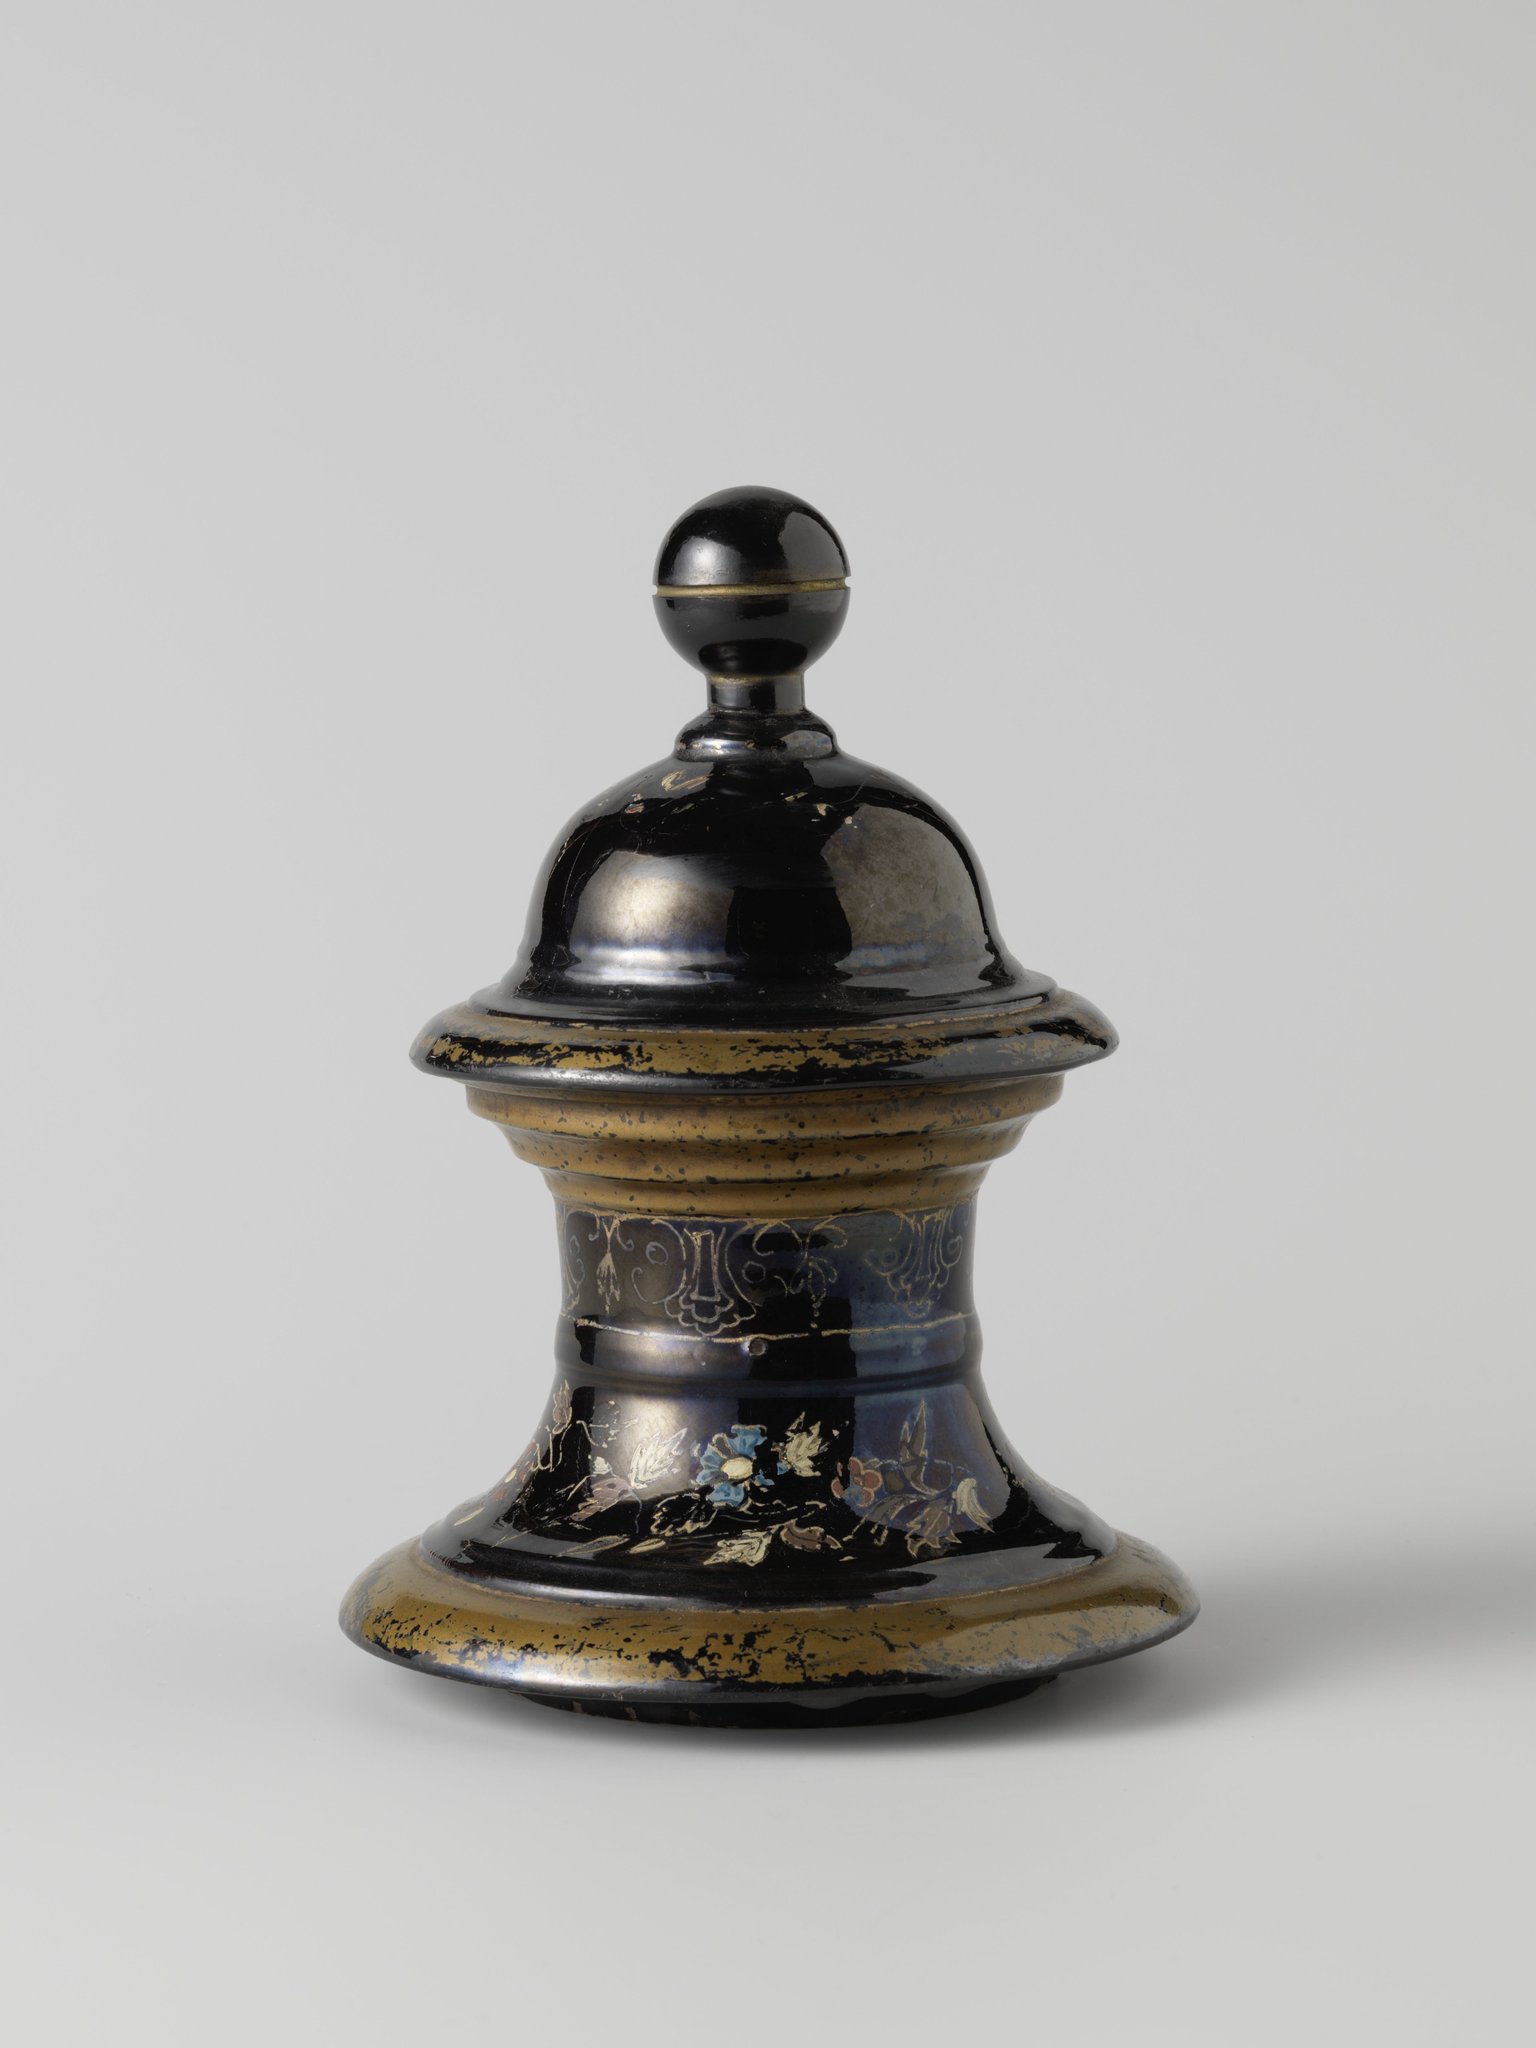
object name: lid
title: Deksel van een vaas, beschilderd met bloem- en bladranken op een zwarte fond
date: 1715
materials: stoneware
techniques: lacquer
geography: meissen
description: Cover. Red stoneware, covered with black glaze, painted with lacquer Meissen, c. 1715. Cup. Meissen, c. 1715.